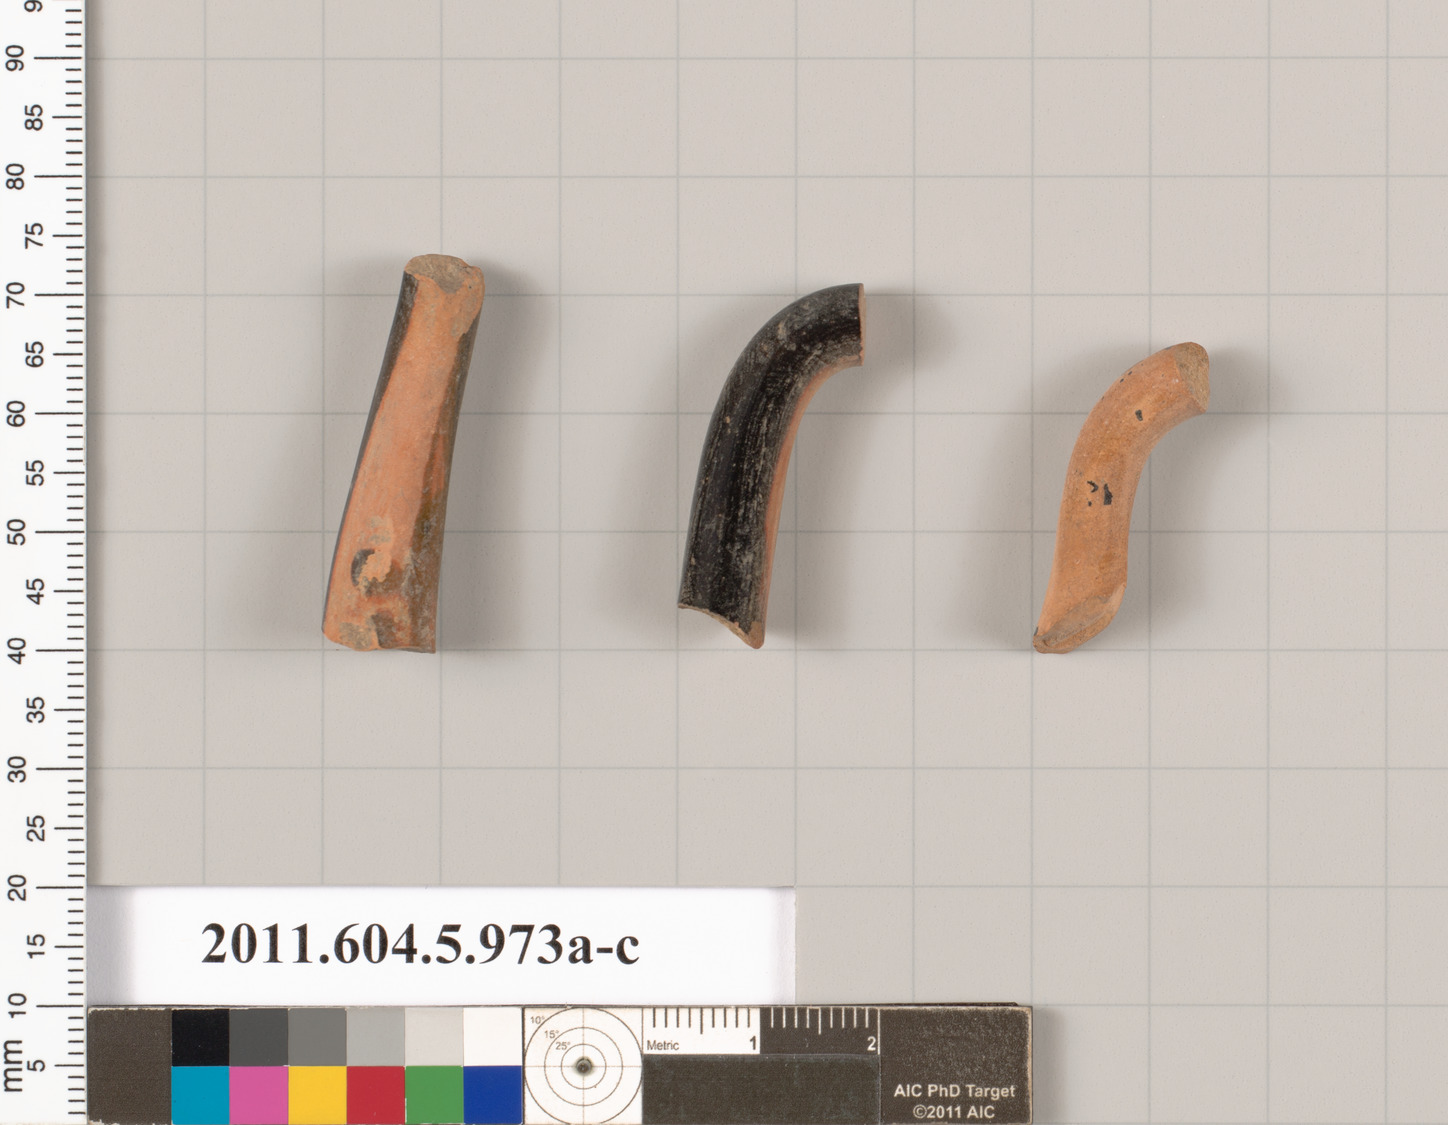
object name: kylix fragment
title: Terracotta fragments of kylikes (drinking cups)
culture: greek, attic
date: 600-401 BCE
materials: terracotta